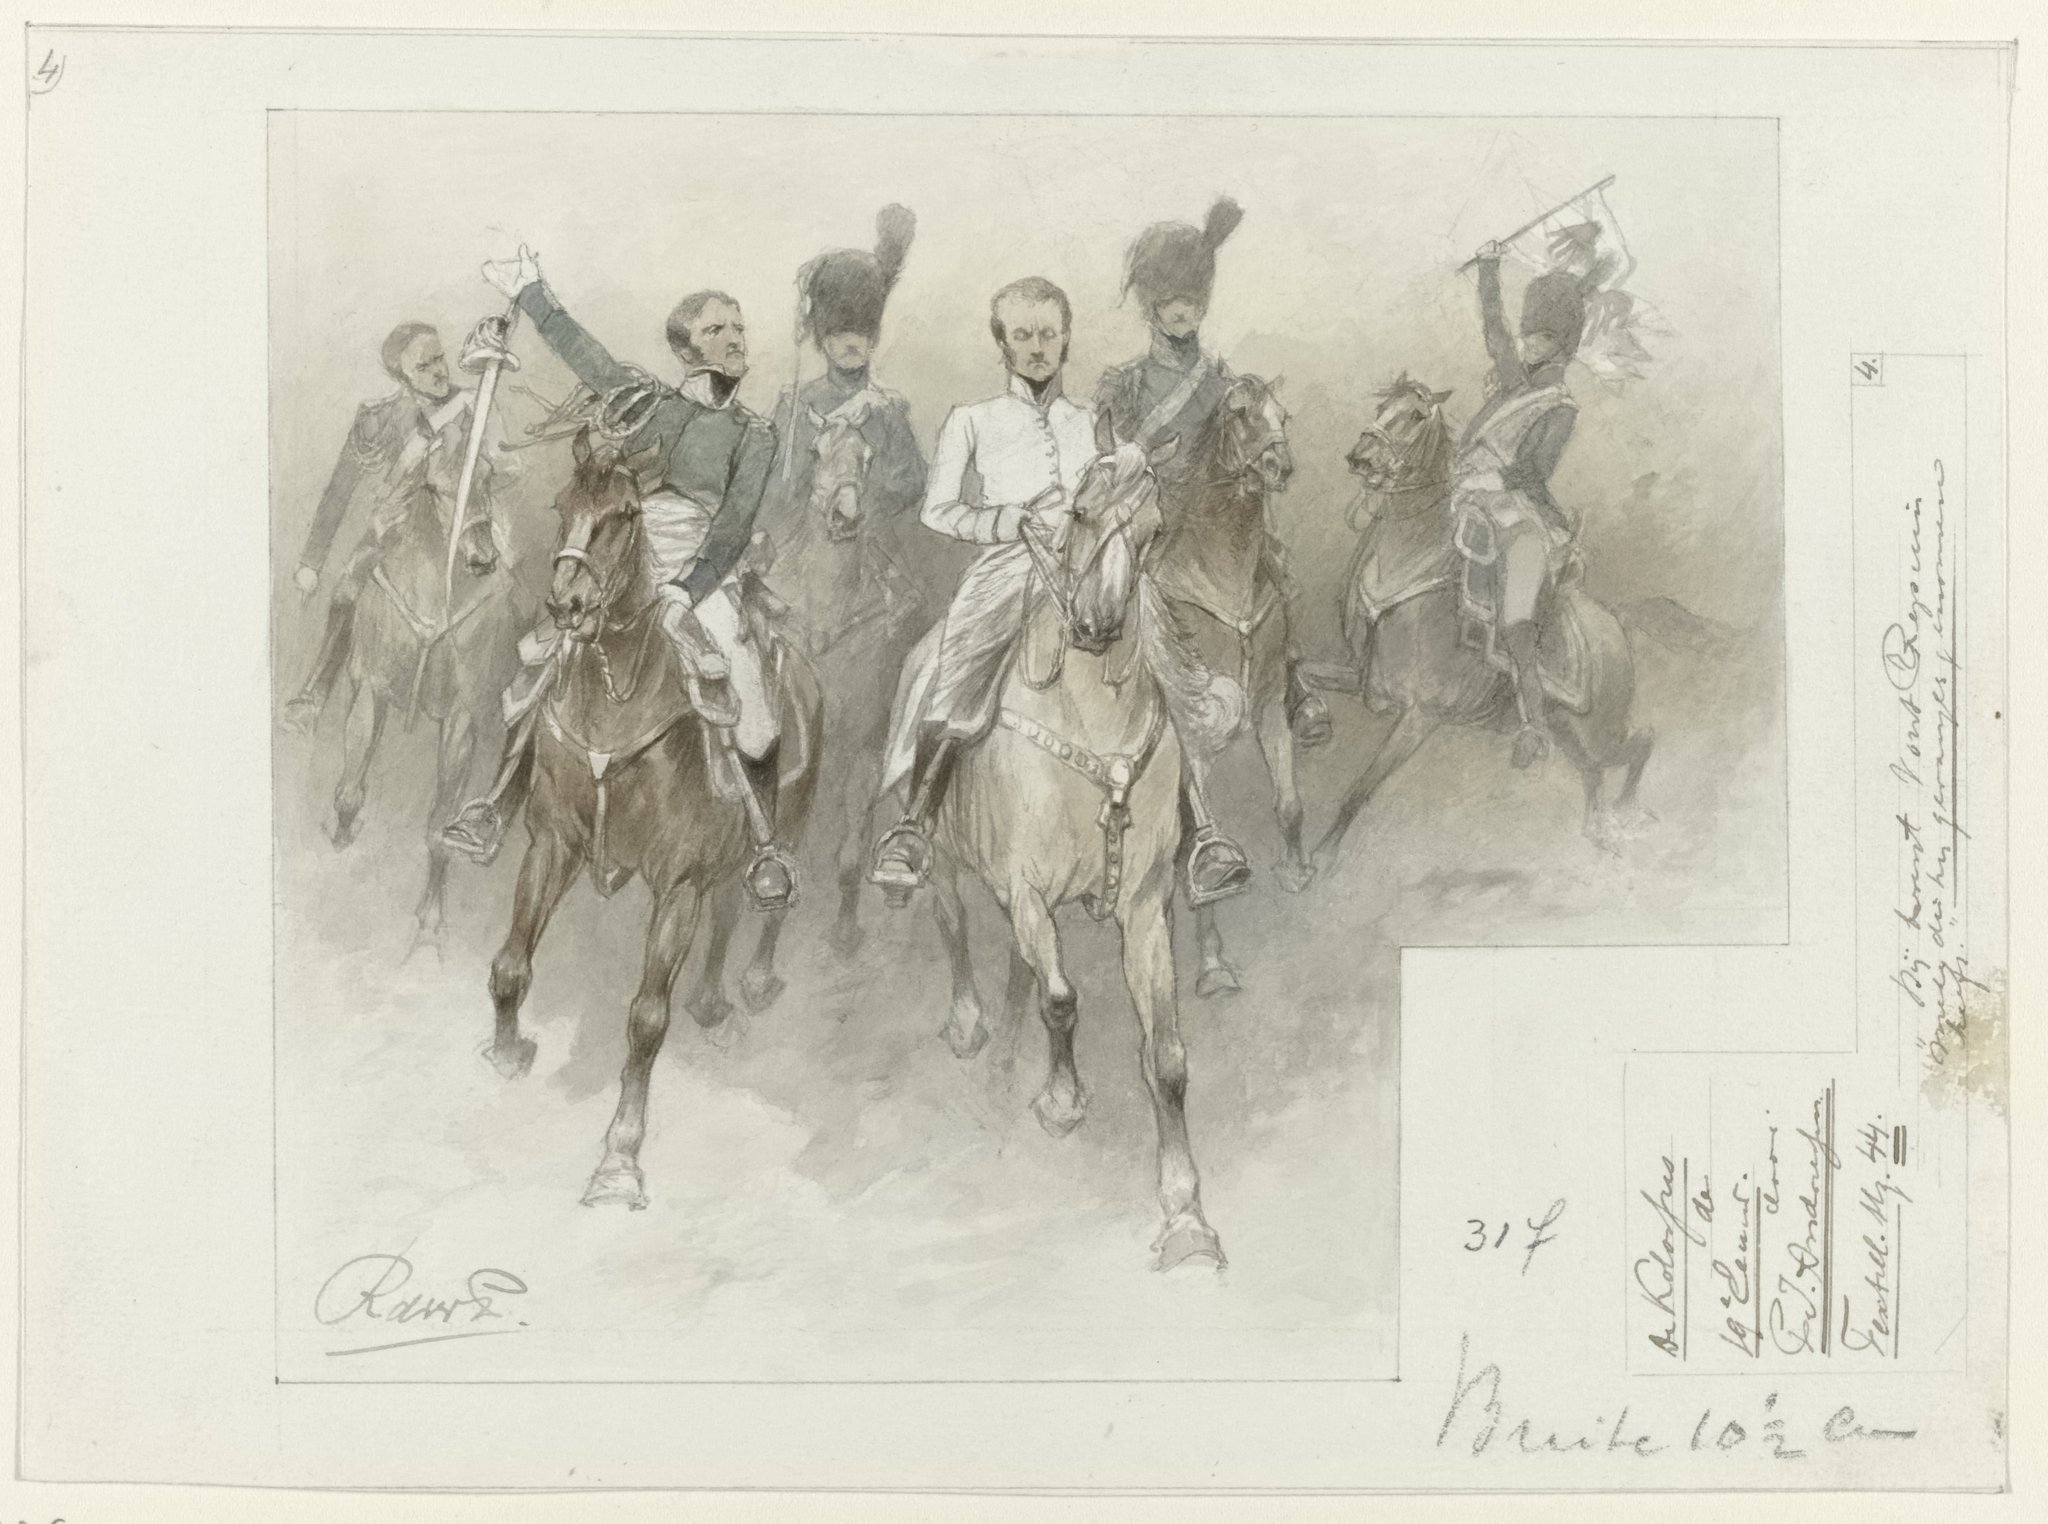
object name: design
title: Ontwerp voor illustratie voor De Kolossus der Negentiende Eeuw door P.J. Andriessen (Textill., blz. 44); scène uit het leven van Napoleon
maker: george lodewijk de wetstein pfister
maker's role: draughtsman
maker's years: 1867-1942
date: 1877-1942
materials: ink, paper, pencil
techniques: brush, pen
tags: napoleon i (emperor of the french), (andriessen, de kolossus der negentiende eeuw) specific works of literature (with author, title), historical persons, illustration ~ printed matter, book, historical events and situations